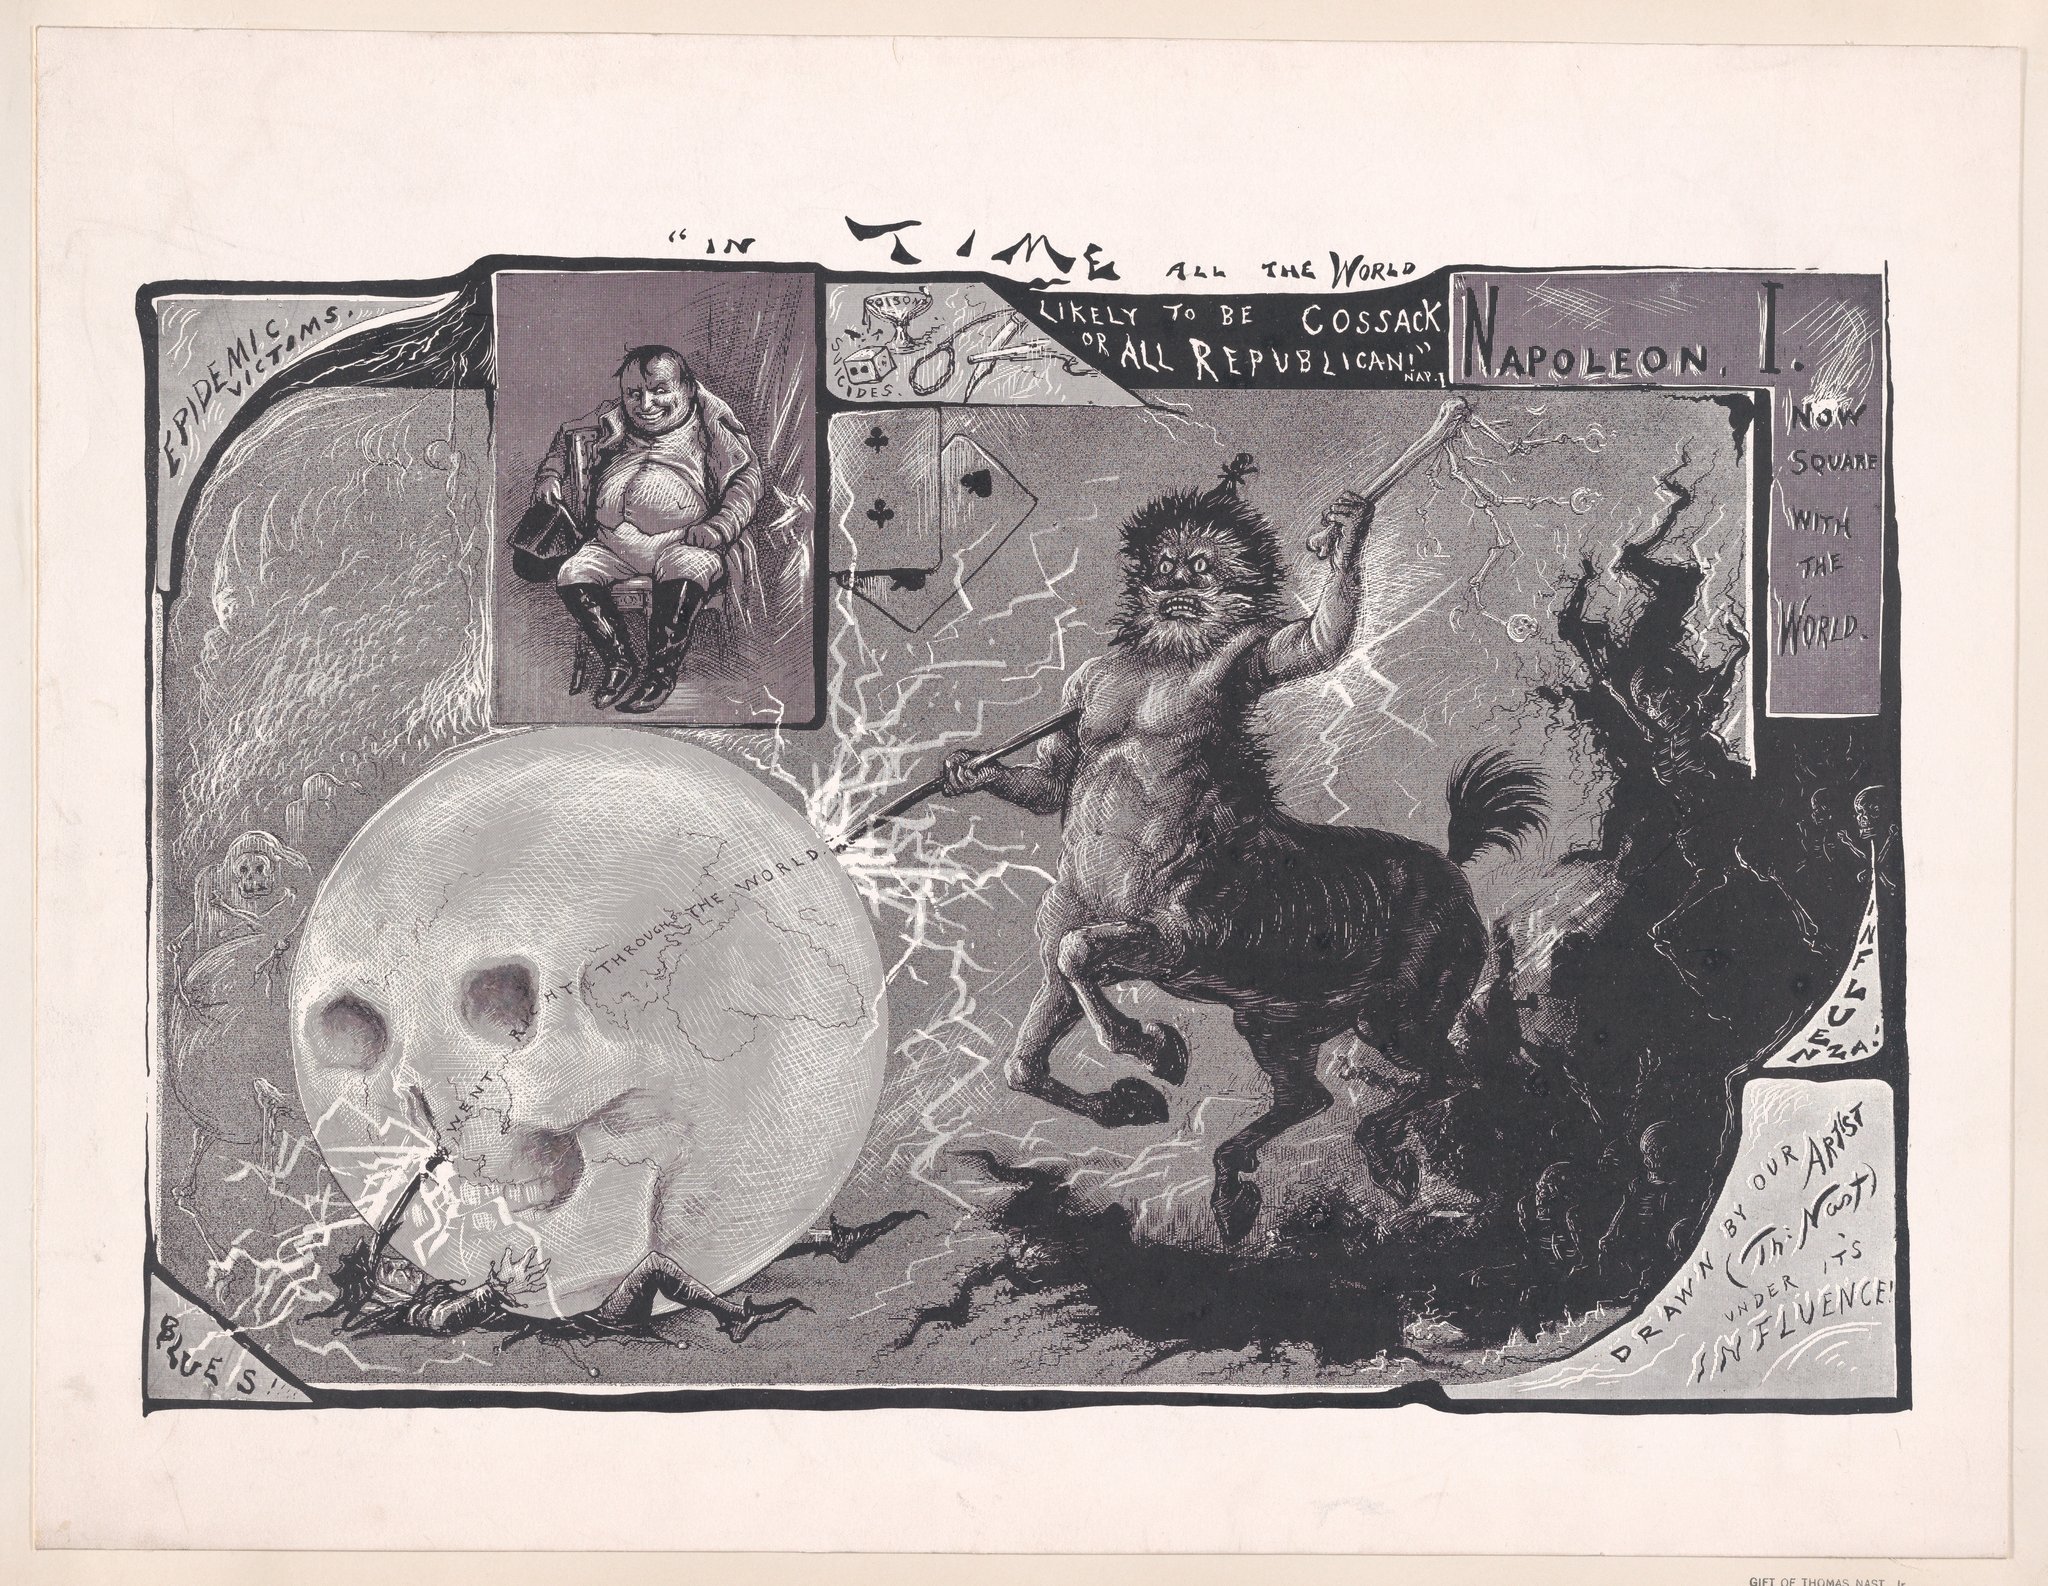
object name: print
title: "In Time All the World Likely to be Cossack or All Republican" – Napoleon I (published in "Time")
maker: thomas nast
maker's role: artist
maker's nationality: american, born germany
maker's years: 1840-1902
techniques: relief print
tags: napoleon i,skulls,centaurs,globes